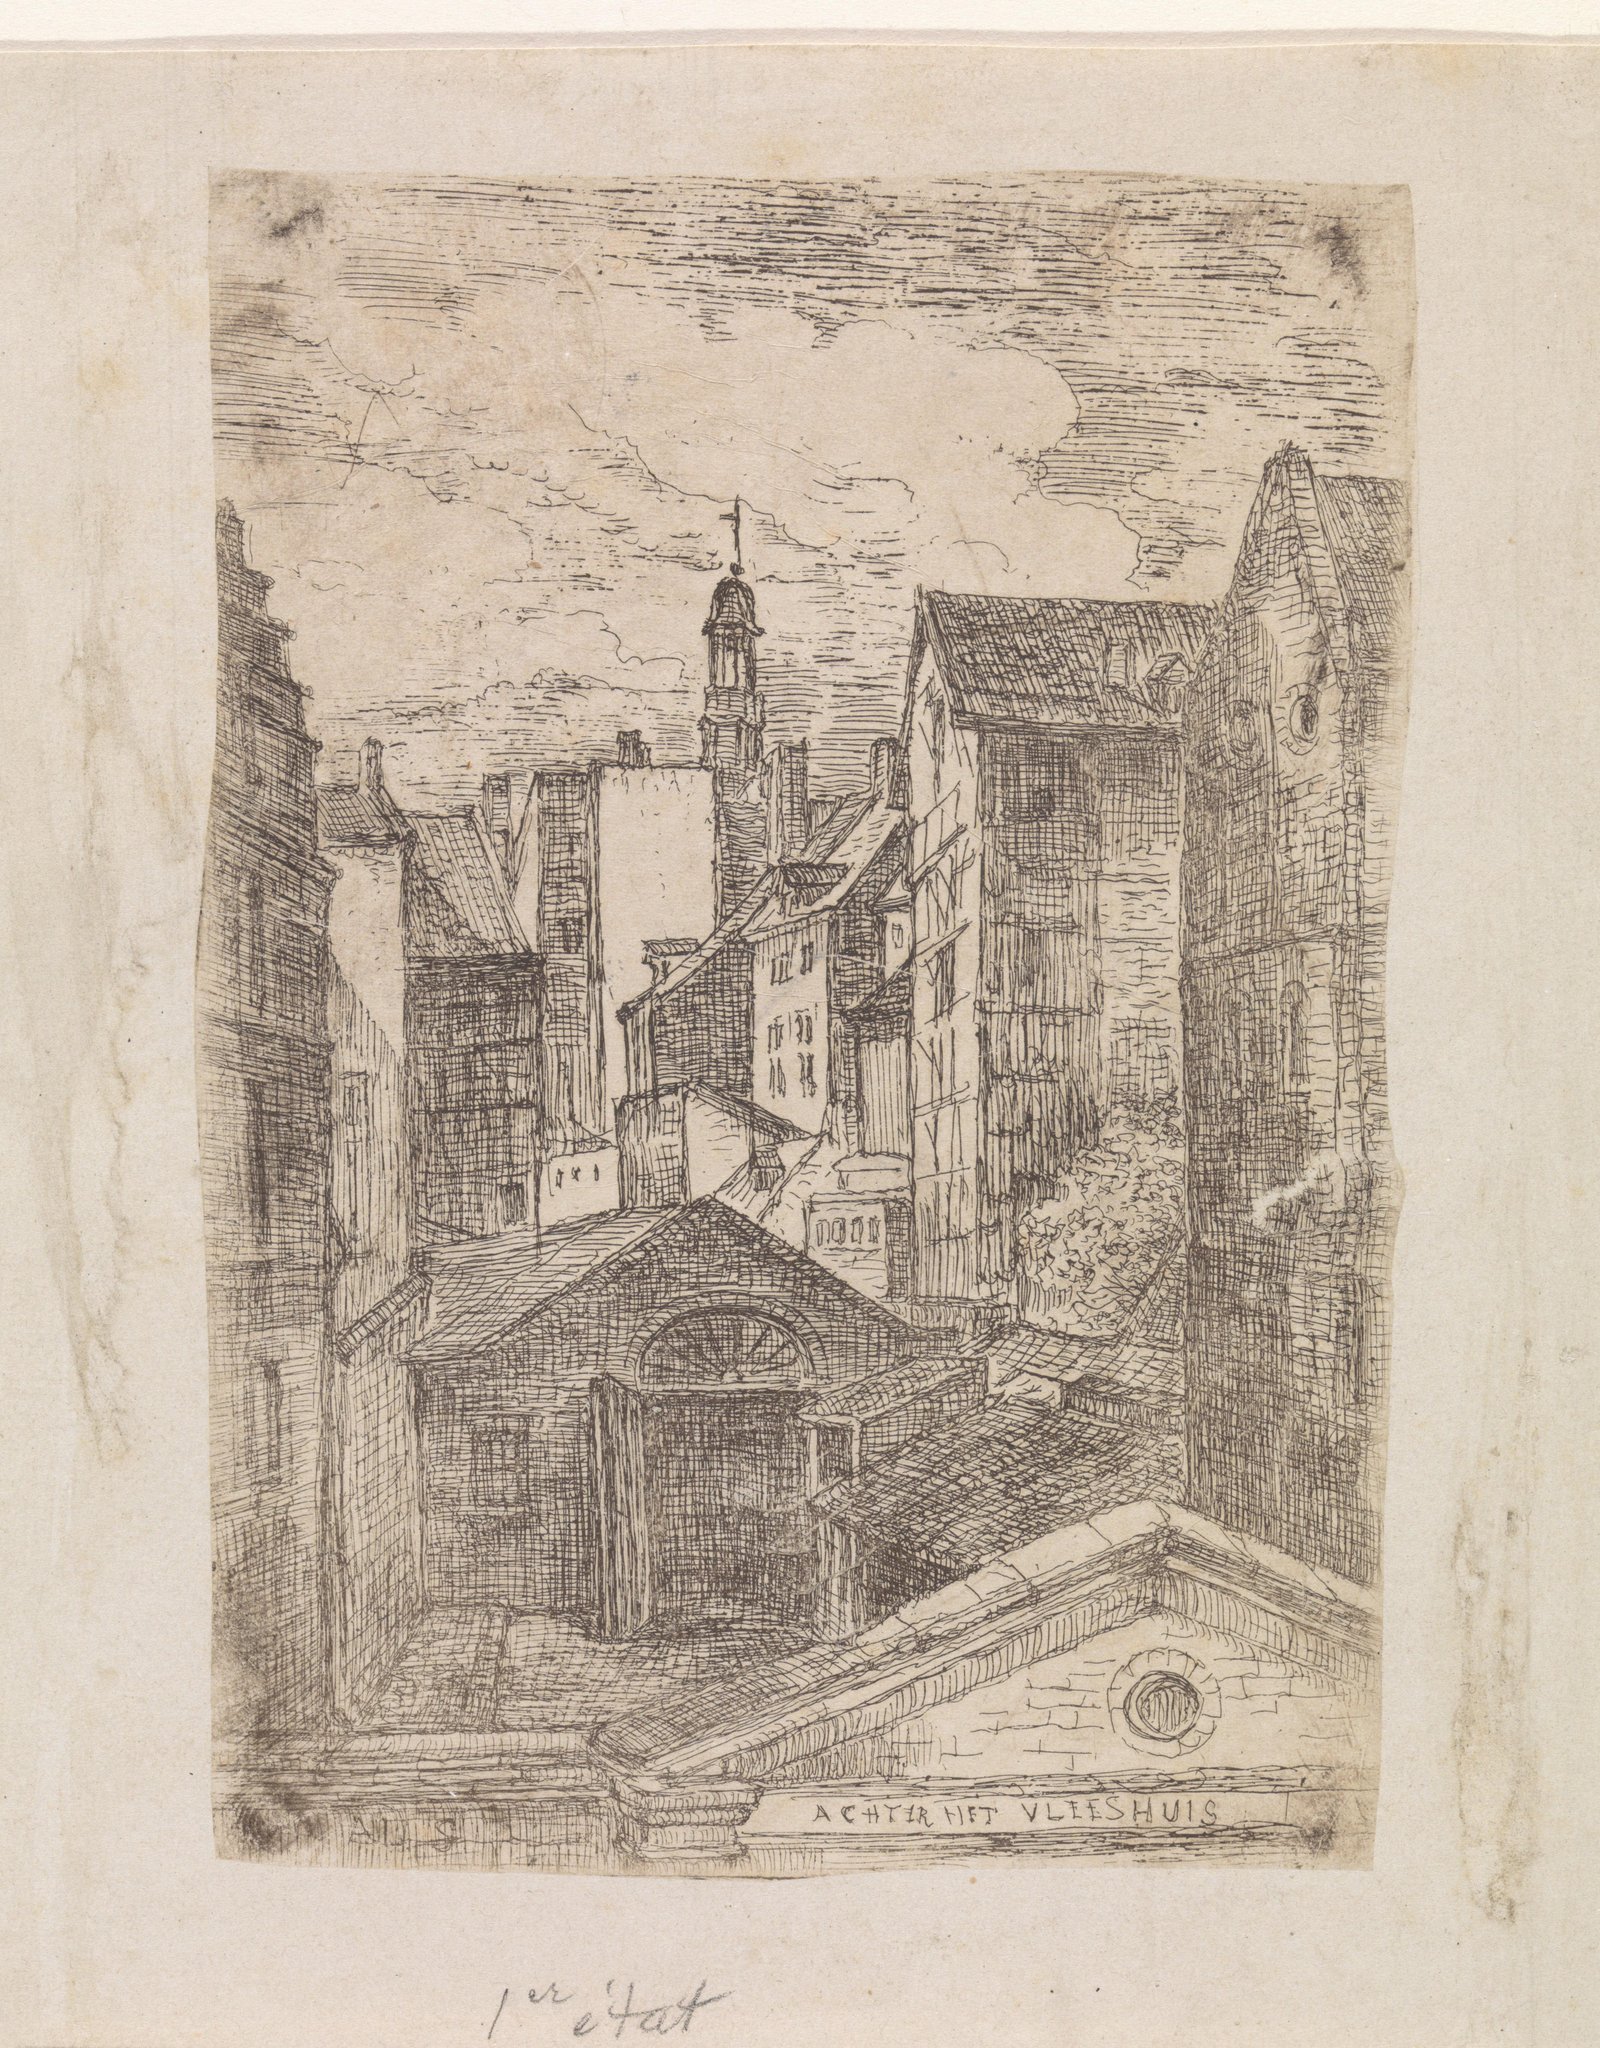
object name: print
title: Achter het Vleeshuis, Maastricht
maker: alexander schaepkens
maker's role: draughtsman, print maker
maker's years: 1815-1899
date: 1830-1899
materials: paper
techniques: etching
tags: city-view, and landscape with man-made constructions, maastricht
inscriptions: collector's mark: Lugt 2228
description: De poort gaf toegang tot het Vleeshuis, waar in vroeger tijden de slagers hun waar verkochten. Het perceel liep door tot in de Grote Staat, waar de hoofingang was.